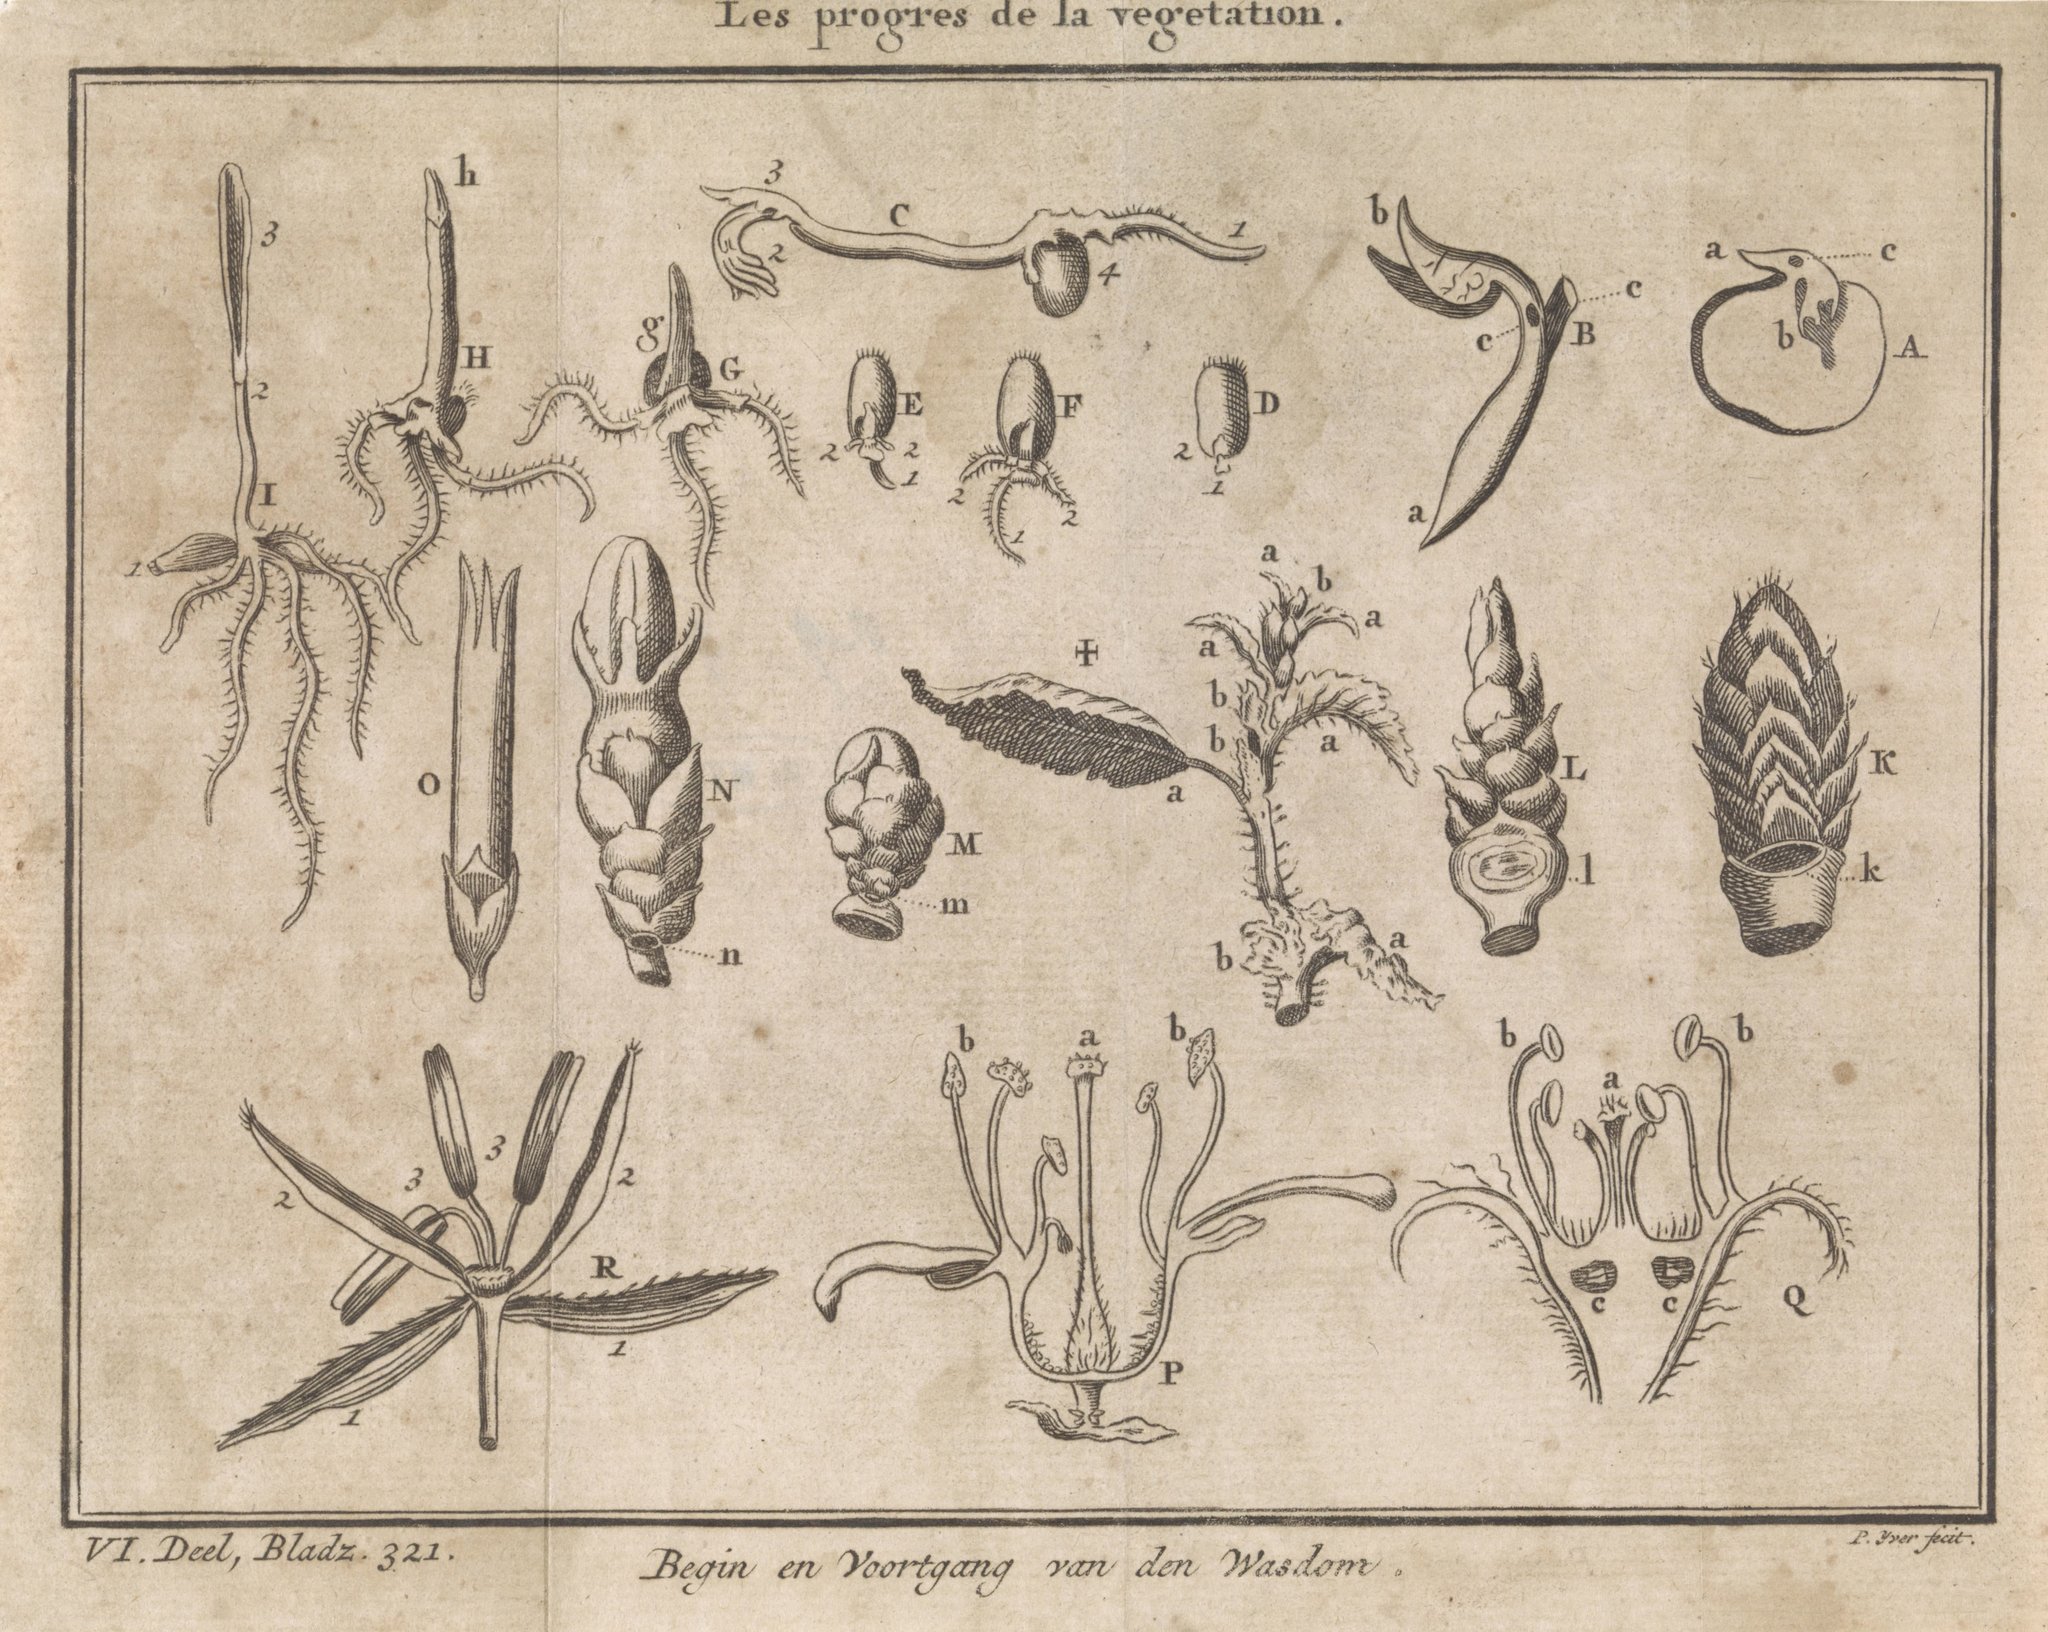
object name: print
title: Les Progrès de la vegetation / Begin en Voortgang van den Wasdom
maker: pieter yver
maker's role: print maker, publisher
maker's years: 1712-1787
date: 1722-1782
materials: paper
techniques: etching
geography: amsterdam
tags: plants; vegetation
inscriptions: collector's mark: Lugt 2228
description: Prent uit een van de delen van: Pluche, Noël Antoine. Le spectacle de la nature, ou Entretiens sur les particularités de l'histoire naturelle. 4 dln. Den Haag: Jean Neaulme, 1735-1739.